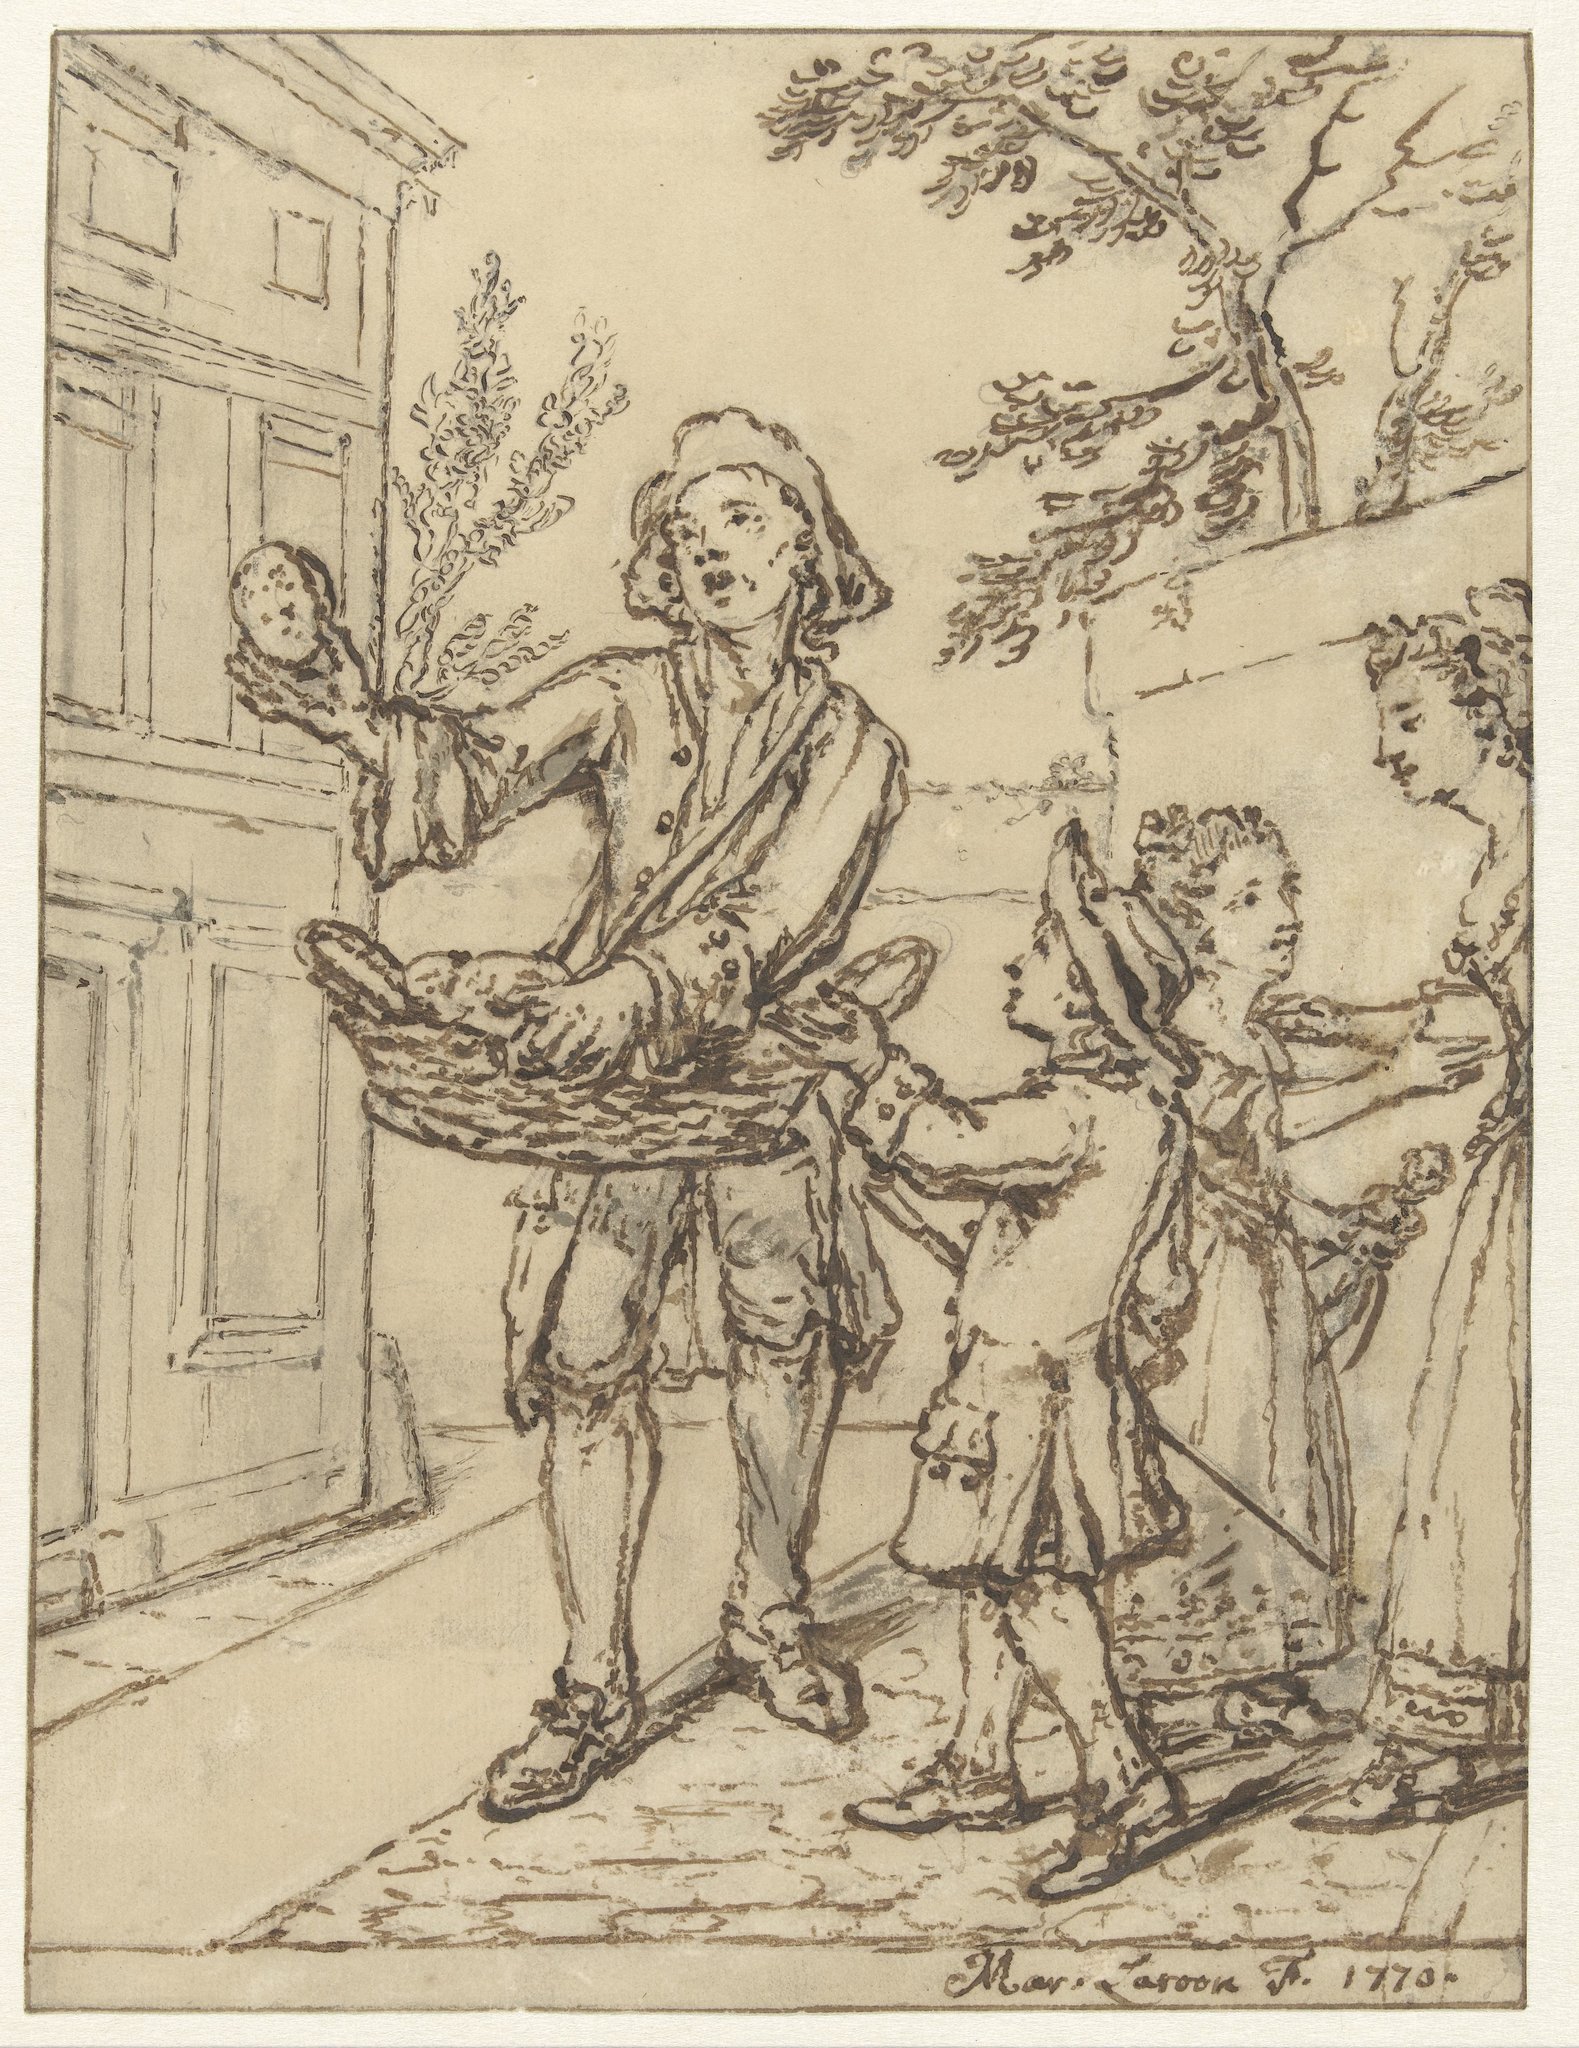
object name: drawing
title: Jonge koopman bij drie kinderen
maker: marcellus laroon (ii)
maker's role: draughtsman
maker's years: 1679-1774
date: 1770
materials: chalk, ink, paper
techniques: pen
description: Een jonge koopman met een mand met koeken, bij een drietal kinderen.